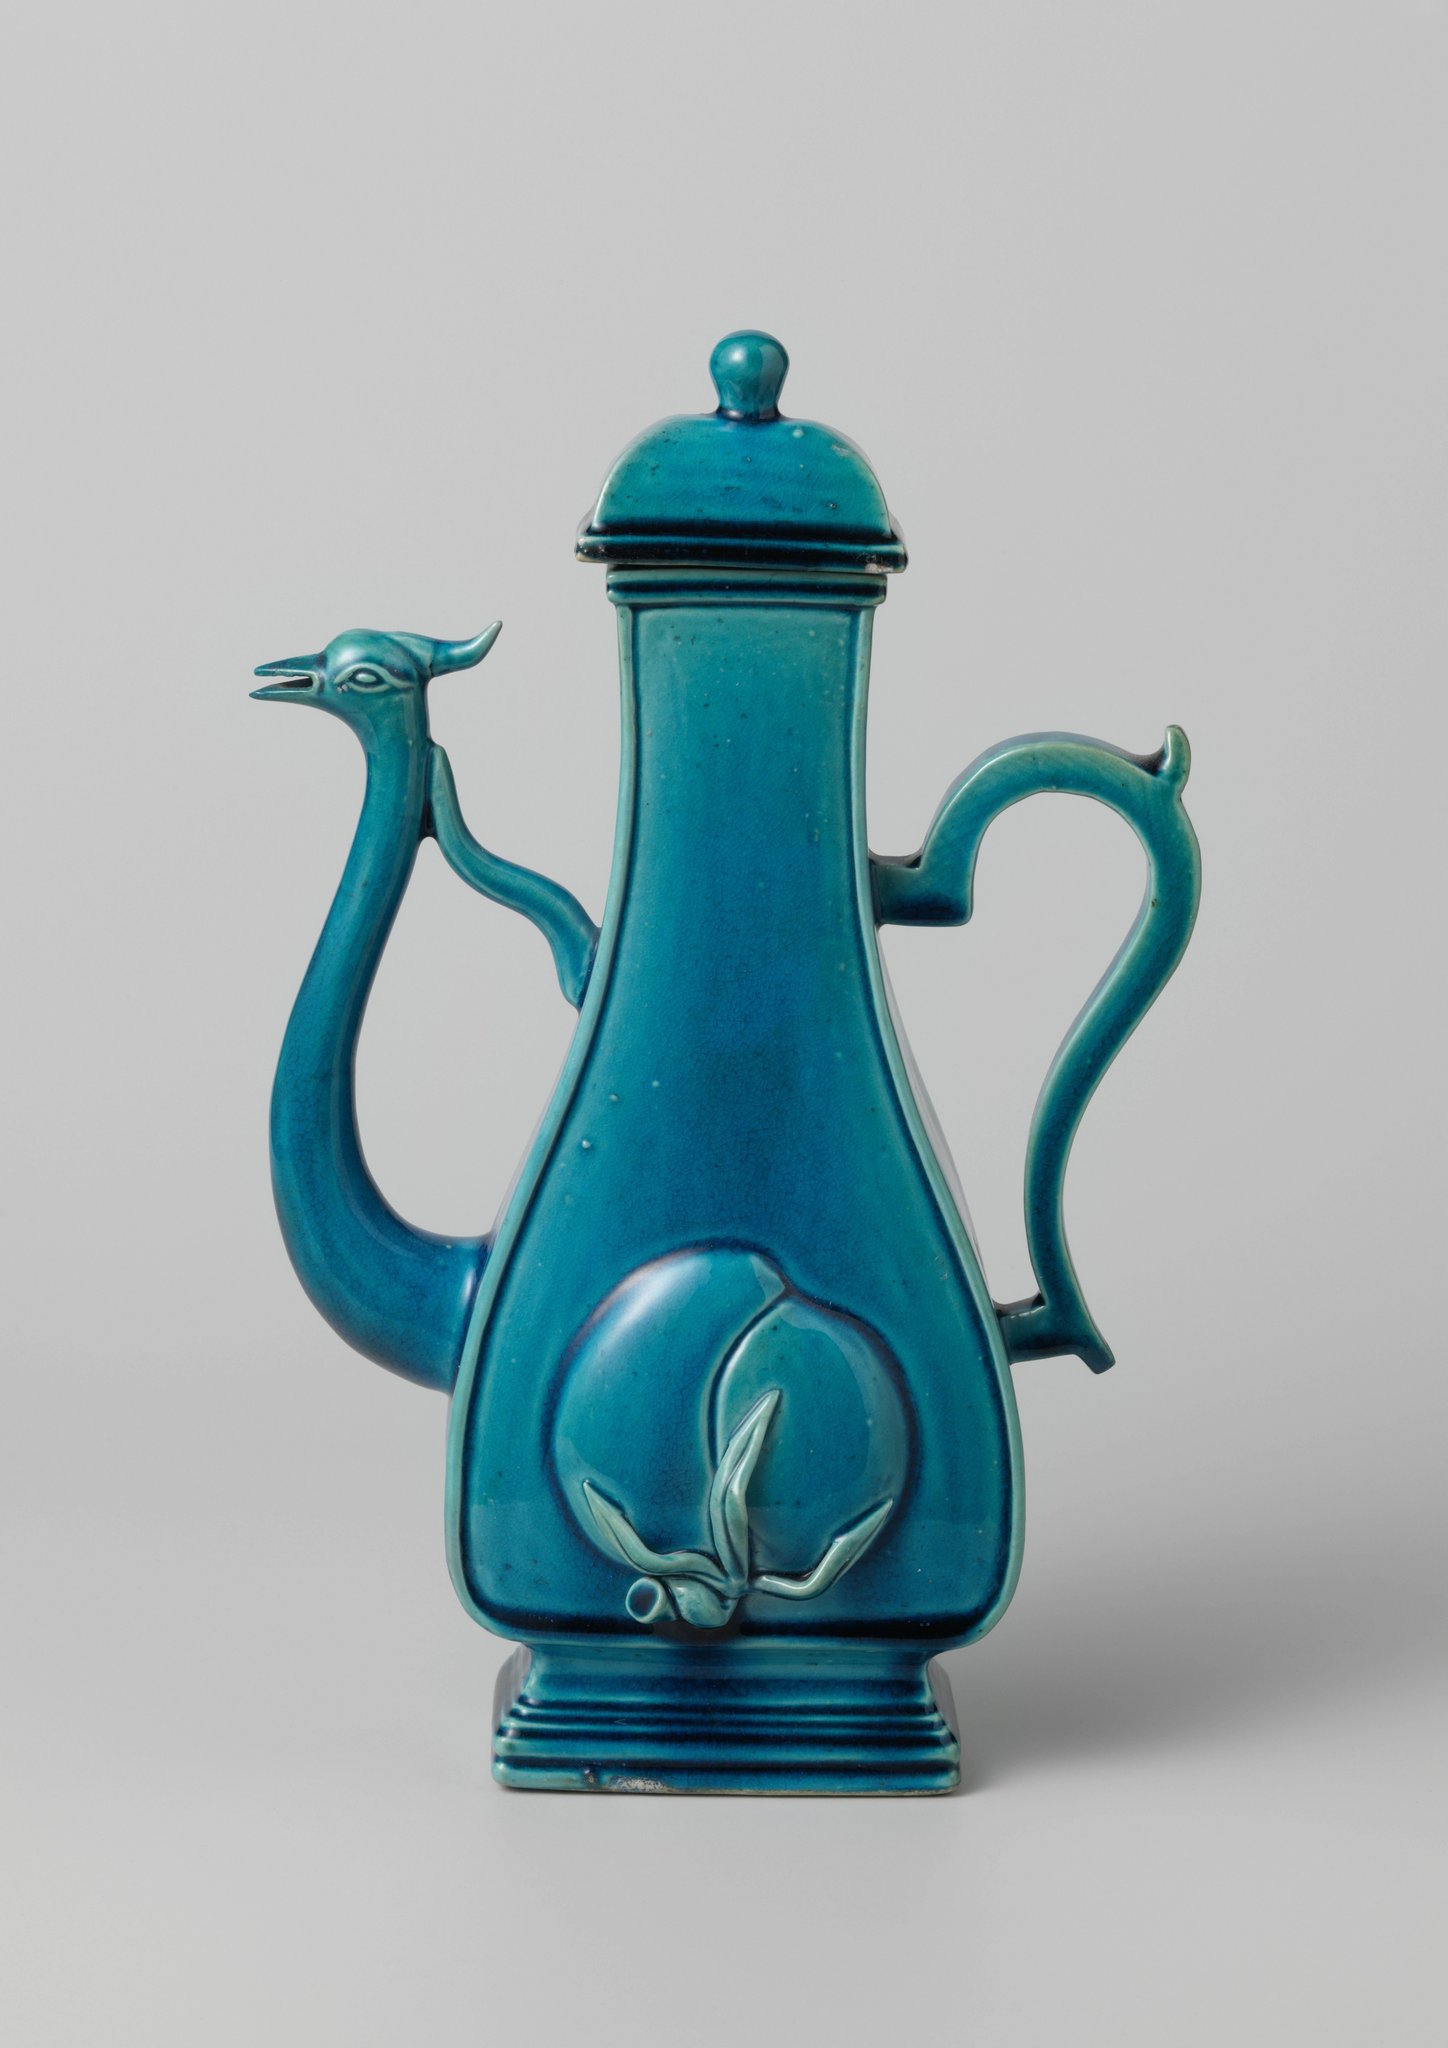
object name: lid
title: Pear-shaped wine ewer with peach and spout ending in a bird's head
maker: Anonymous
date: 1800-1899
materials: glaze, porcelain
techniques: firing, forming, vitrification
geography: china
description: Deksel van wijnkan van porselein, bedekt met een turquoise glazuur. Monochromen.